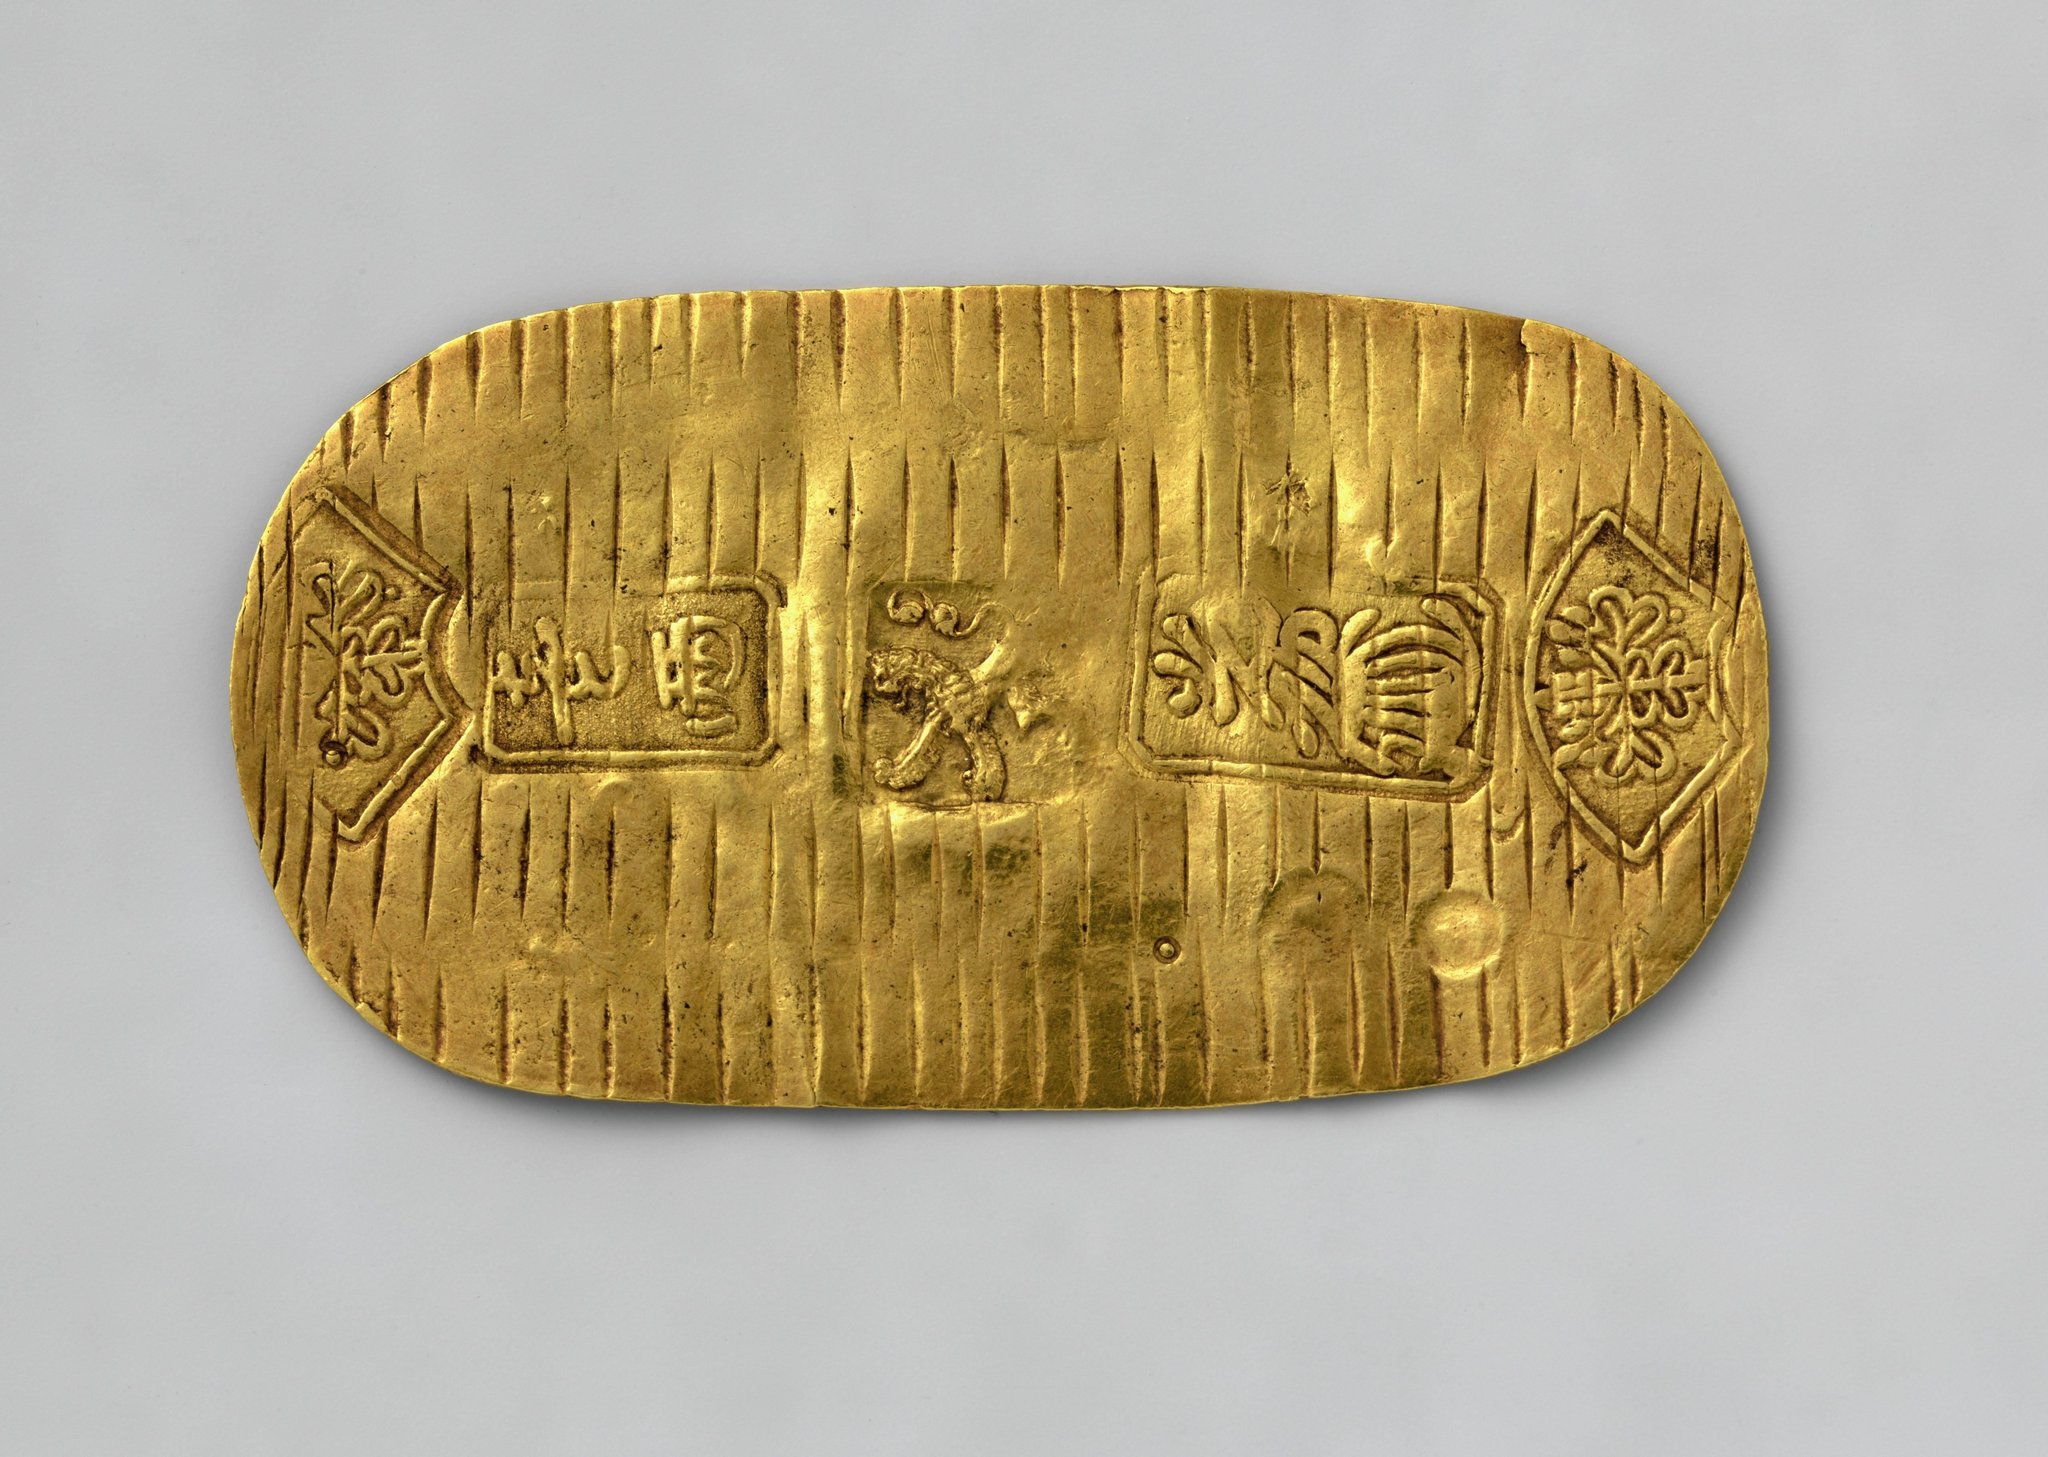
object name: coin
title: Japanese koban with a stamp (coat of arms of Holland) applied in Batavia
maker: Anonymous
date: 1690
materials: gold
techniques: striking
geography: batavia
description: Money often already existed in areas in Asia that the Netherlands conducted trade with and which became colonies. The Dutch occasionally used these original coins, which often look different from the European ones. At the same time, Dutch money was adapted for the colonies, and sometimes even entirely new coins were minted. The monetary system of the Dutch colonies in Asia and America was therefore a cultural mishmash.